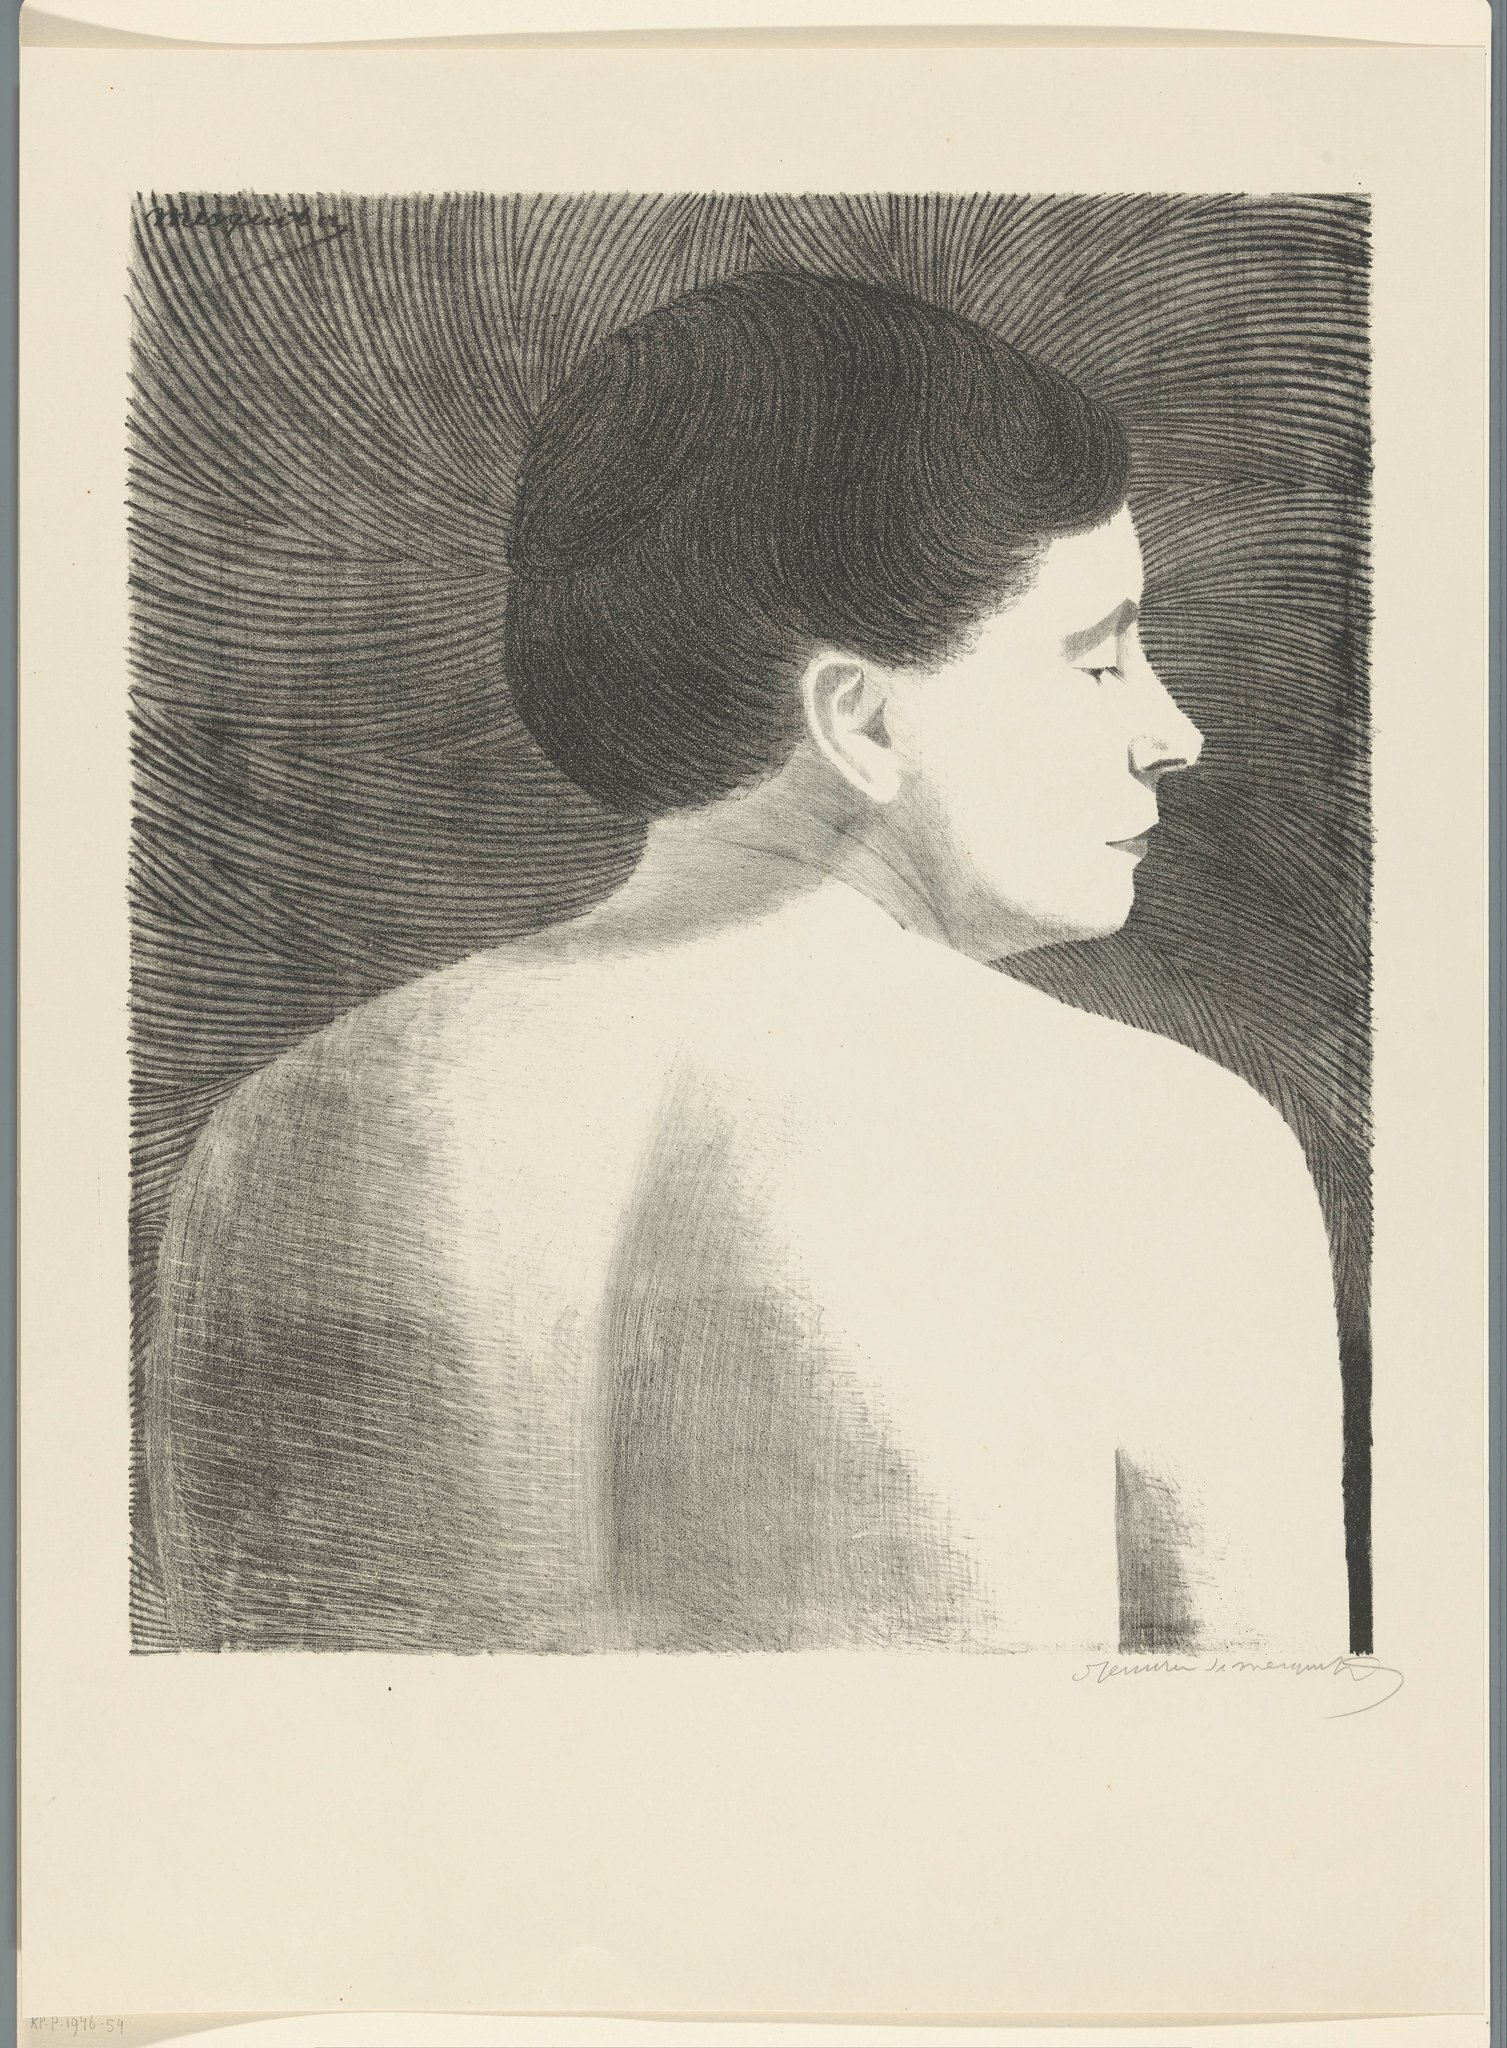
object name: print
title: Op de rug gezien vrouwelijk naakt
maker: samuel jessurun de mesquita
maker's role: draughtsman, print maker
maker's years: 1868-1944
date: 1920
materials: paper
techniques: lithograph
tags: woman (showing herself) undressed, quasi-nude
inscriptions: collector's mark: Lugt 2228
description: Het hoofd is naar rechts gedraaid, de blik naar beneden gericht.